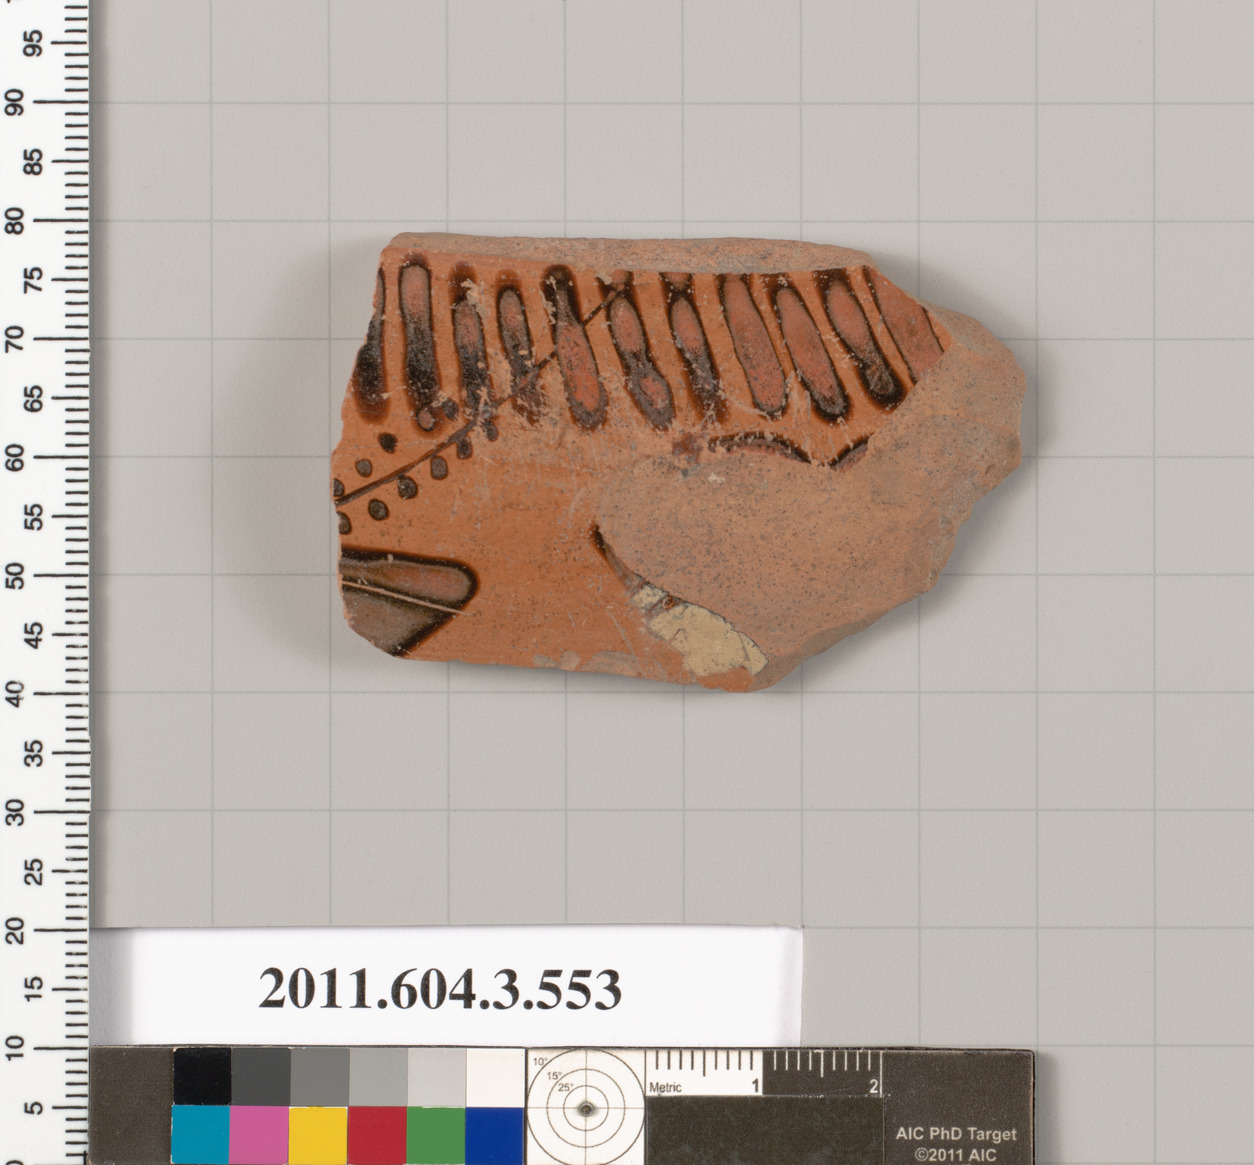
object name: column krater fragment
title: Terracotta fragment of a column-krater (bowl for mixing wine and water)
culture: greek, attic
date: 500-468 BCE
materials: terracotta